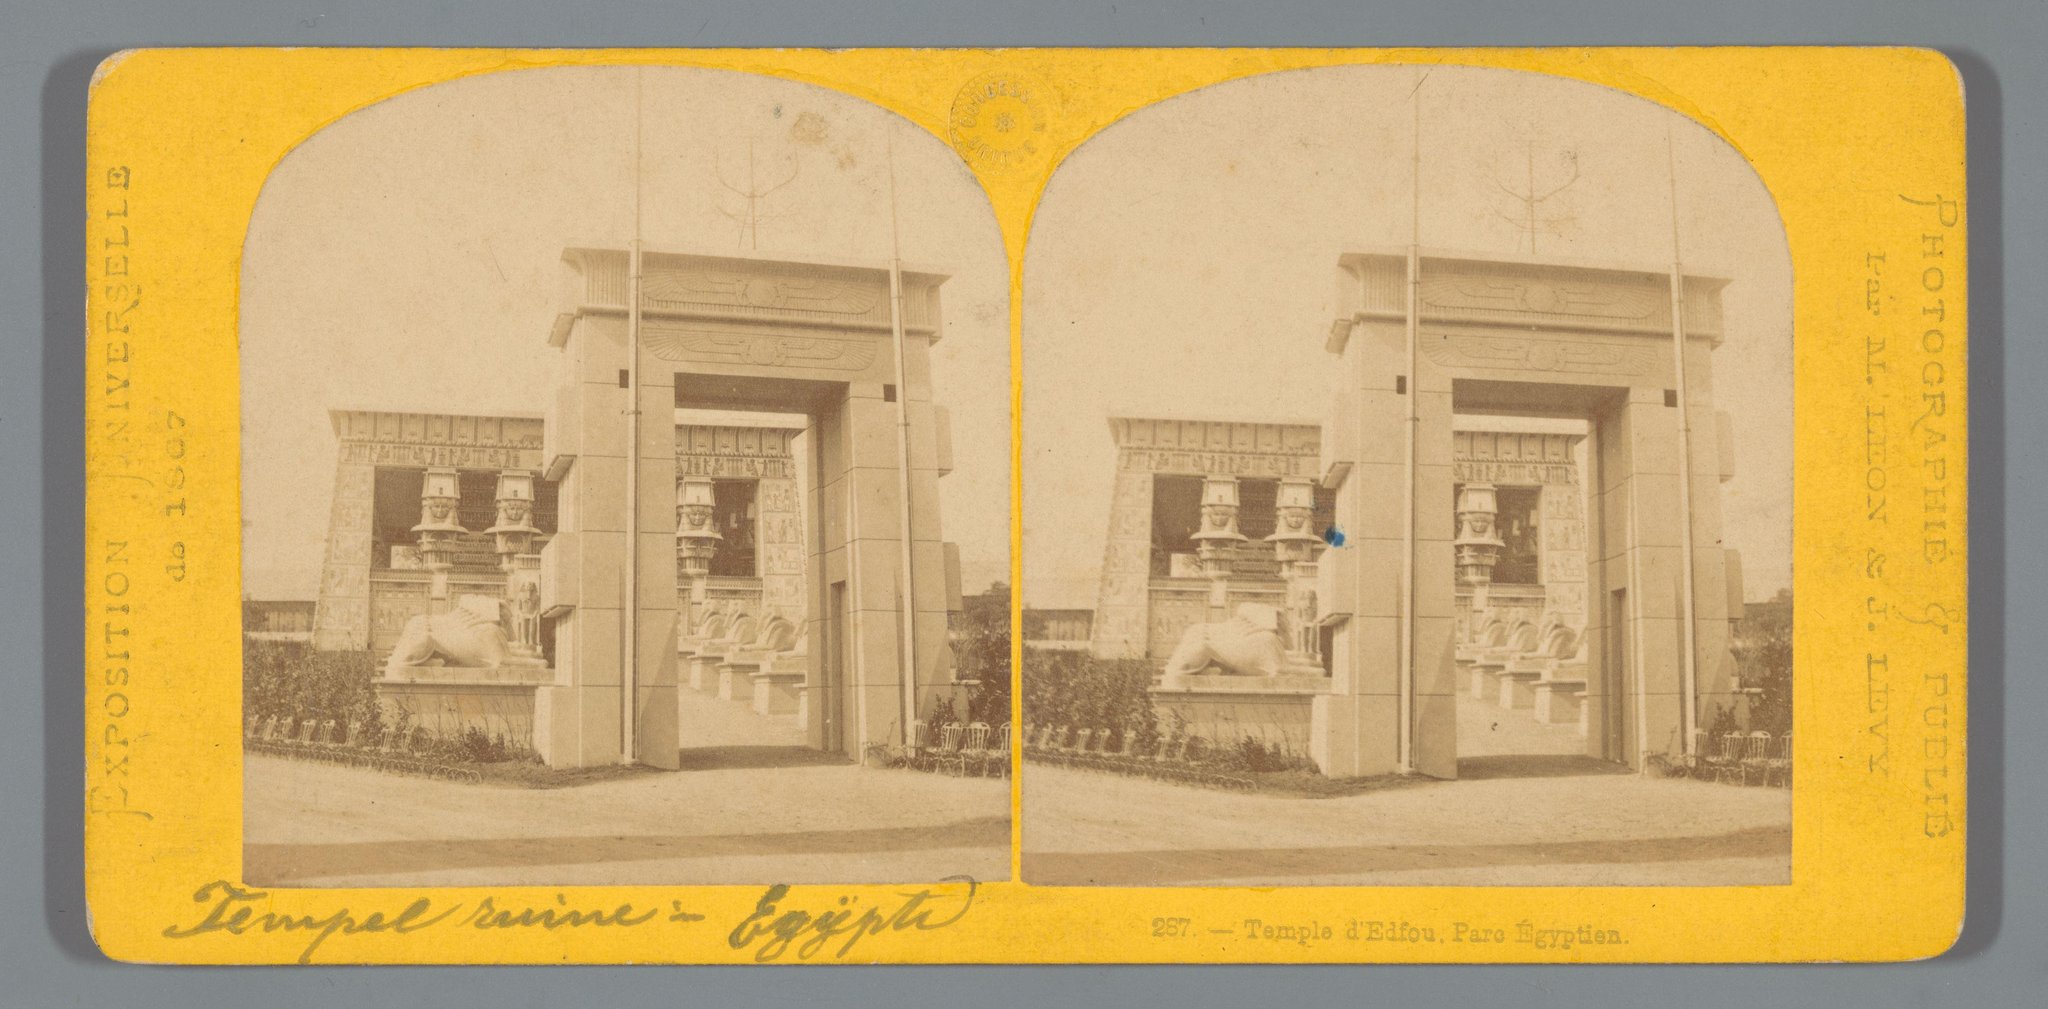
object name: stereograph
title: Tempel van Horus op de Wereldtentoonstelling in 1867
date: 1867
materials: cardboard, paper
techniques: albumen print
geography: paris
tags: world fair, world exhibition, horus, son of osiris and isis, paris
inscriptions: inscription: ‘Egypte Afrika’, inscription: ‘Tempelruïne in Egypte’, number: ‘287.’, inscription: ‘tempelruine Egypte africa’, inscription: ‘Egypte’, check stamp: ‘CONCESSION/ */ UNIQUE’